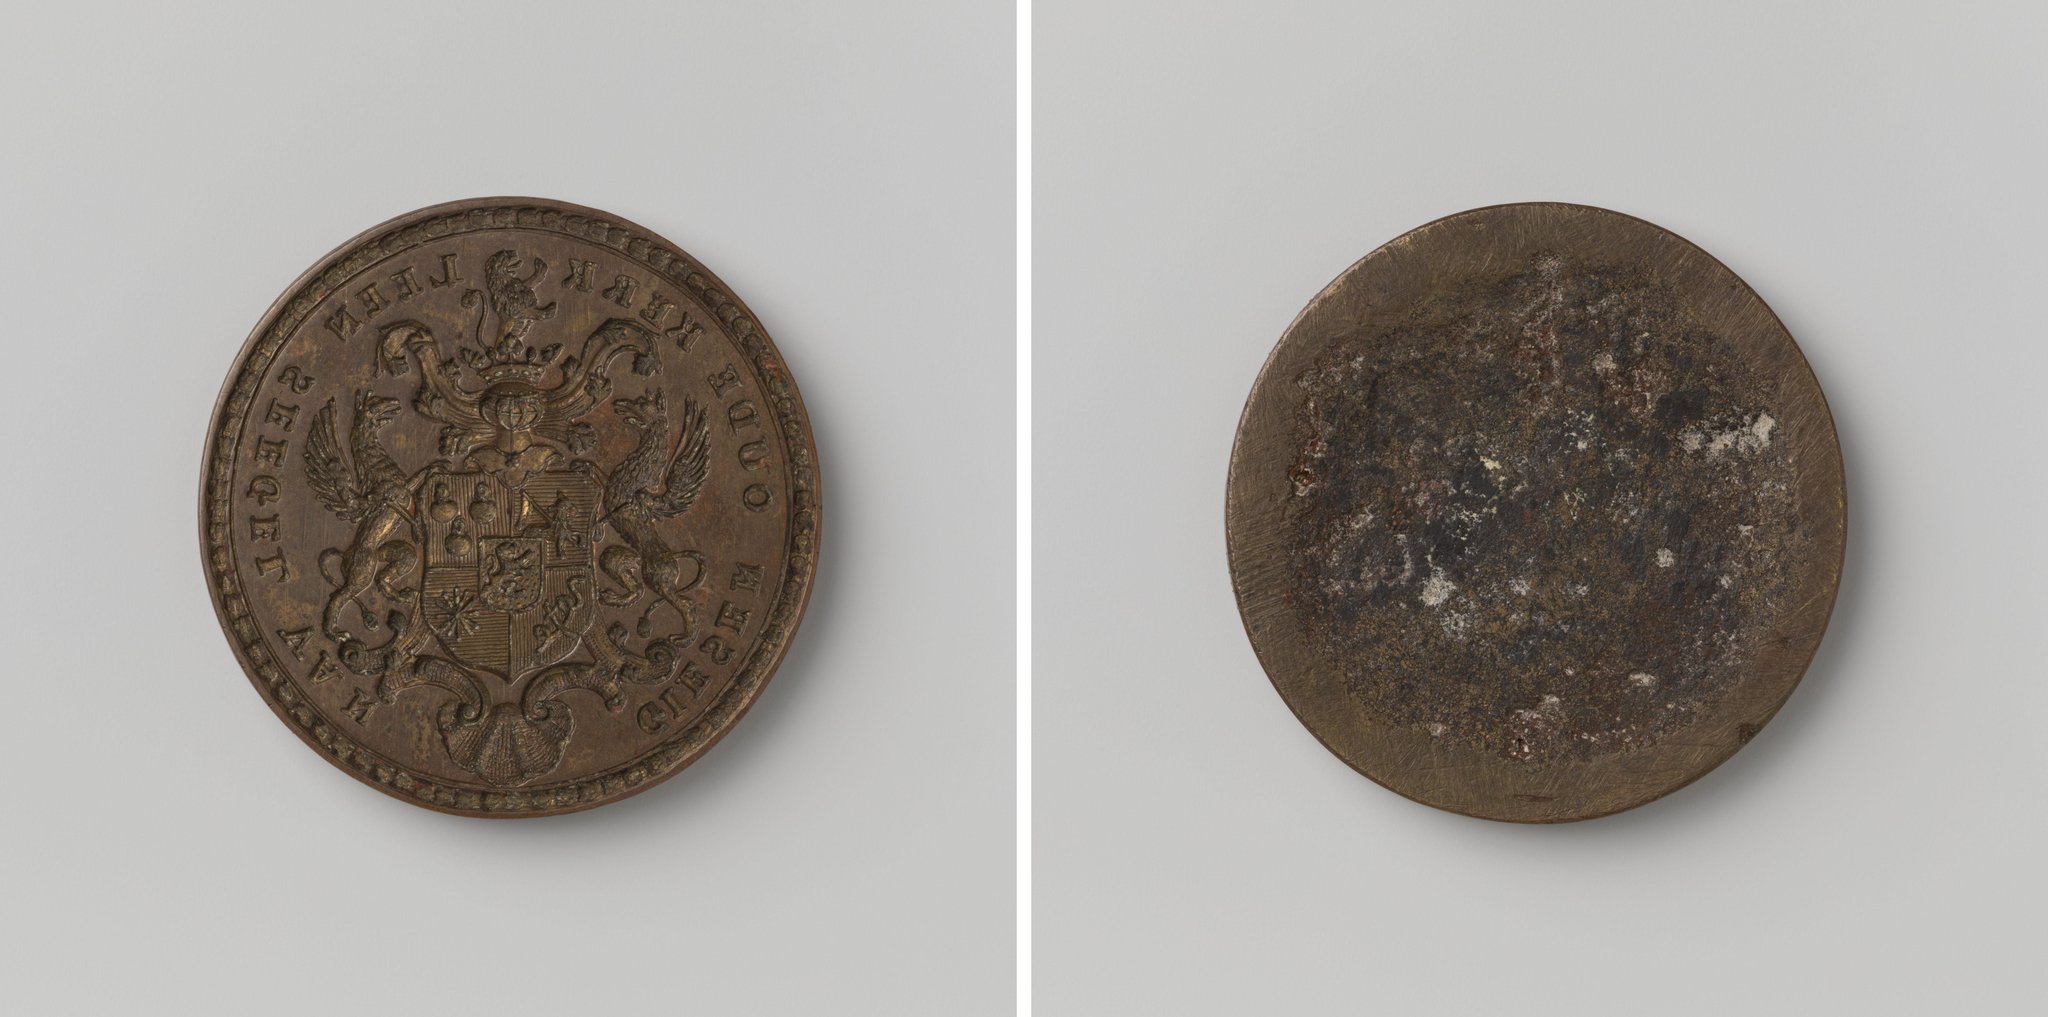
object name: zegelstempel, lakstempel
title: Afdruk in negatief van leenzegel van Giessen-Oudekerk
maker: Anonymous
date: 1550-1650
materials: copper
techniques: striking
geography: netherlands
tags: giessen-oudekerk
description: Eenzijdige koperen afdruk. Voorzijde: wapenschild, bedekt met gekroonde helm en helmteken, geflankeerd door twee griffioenen binnen omschrift. Keerzijde: blanco.